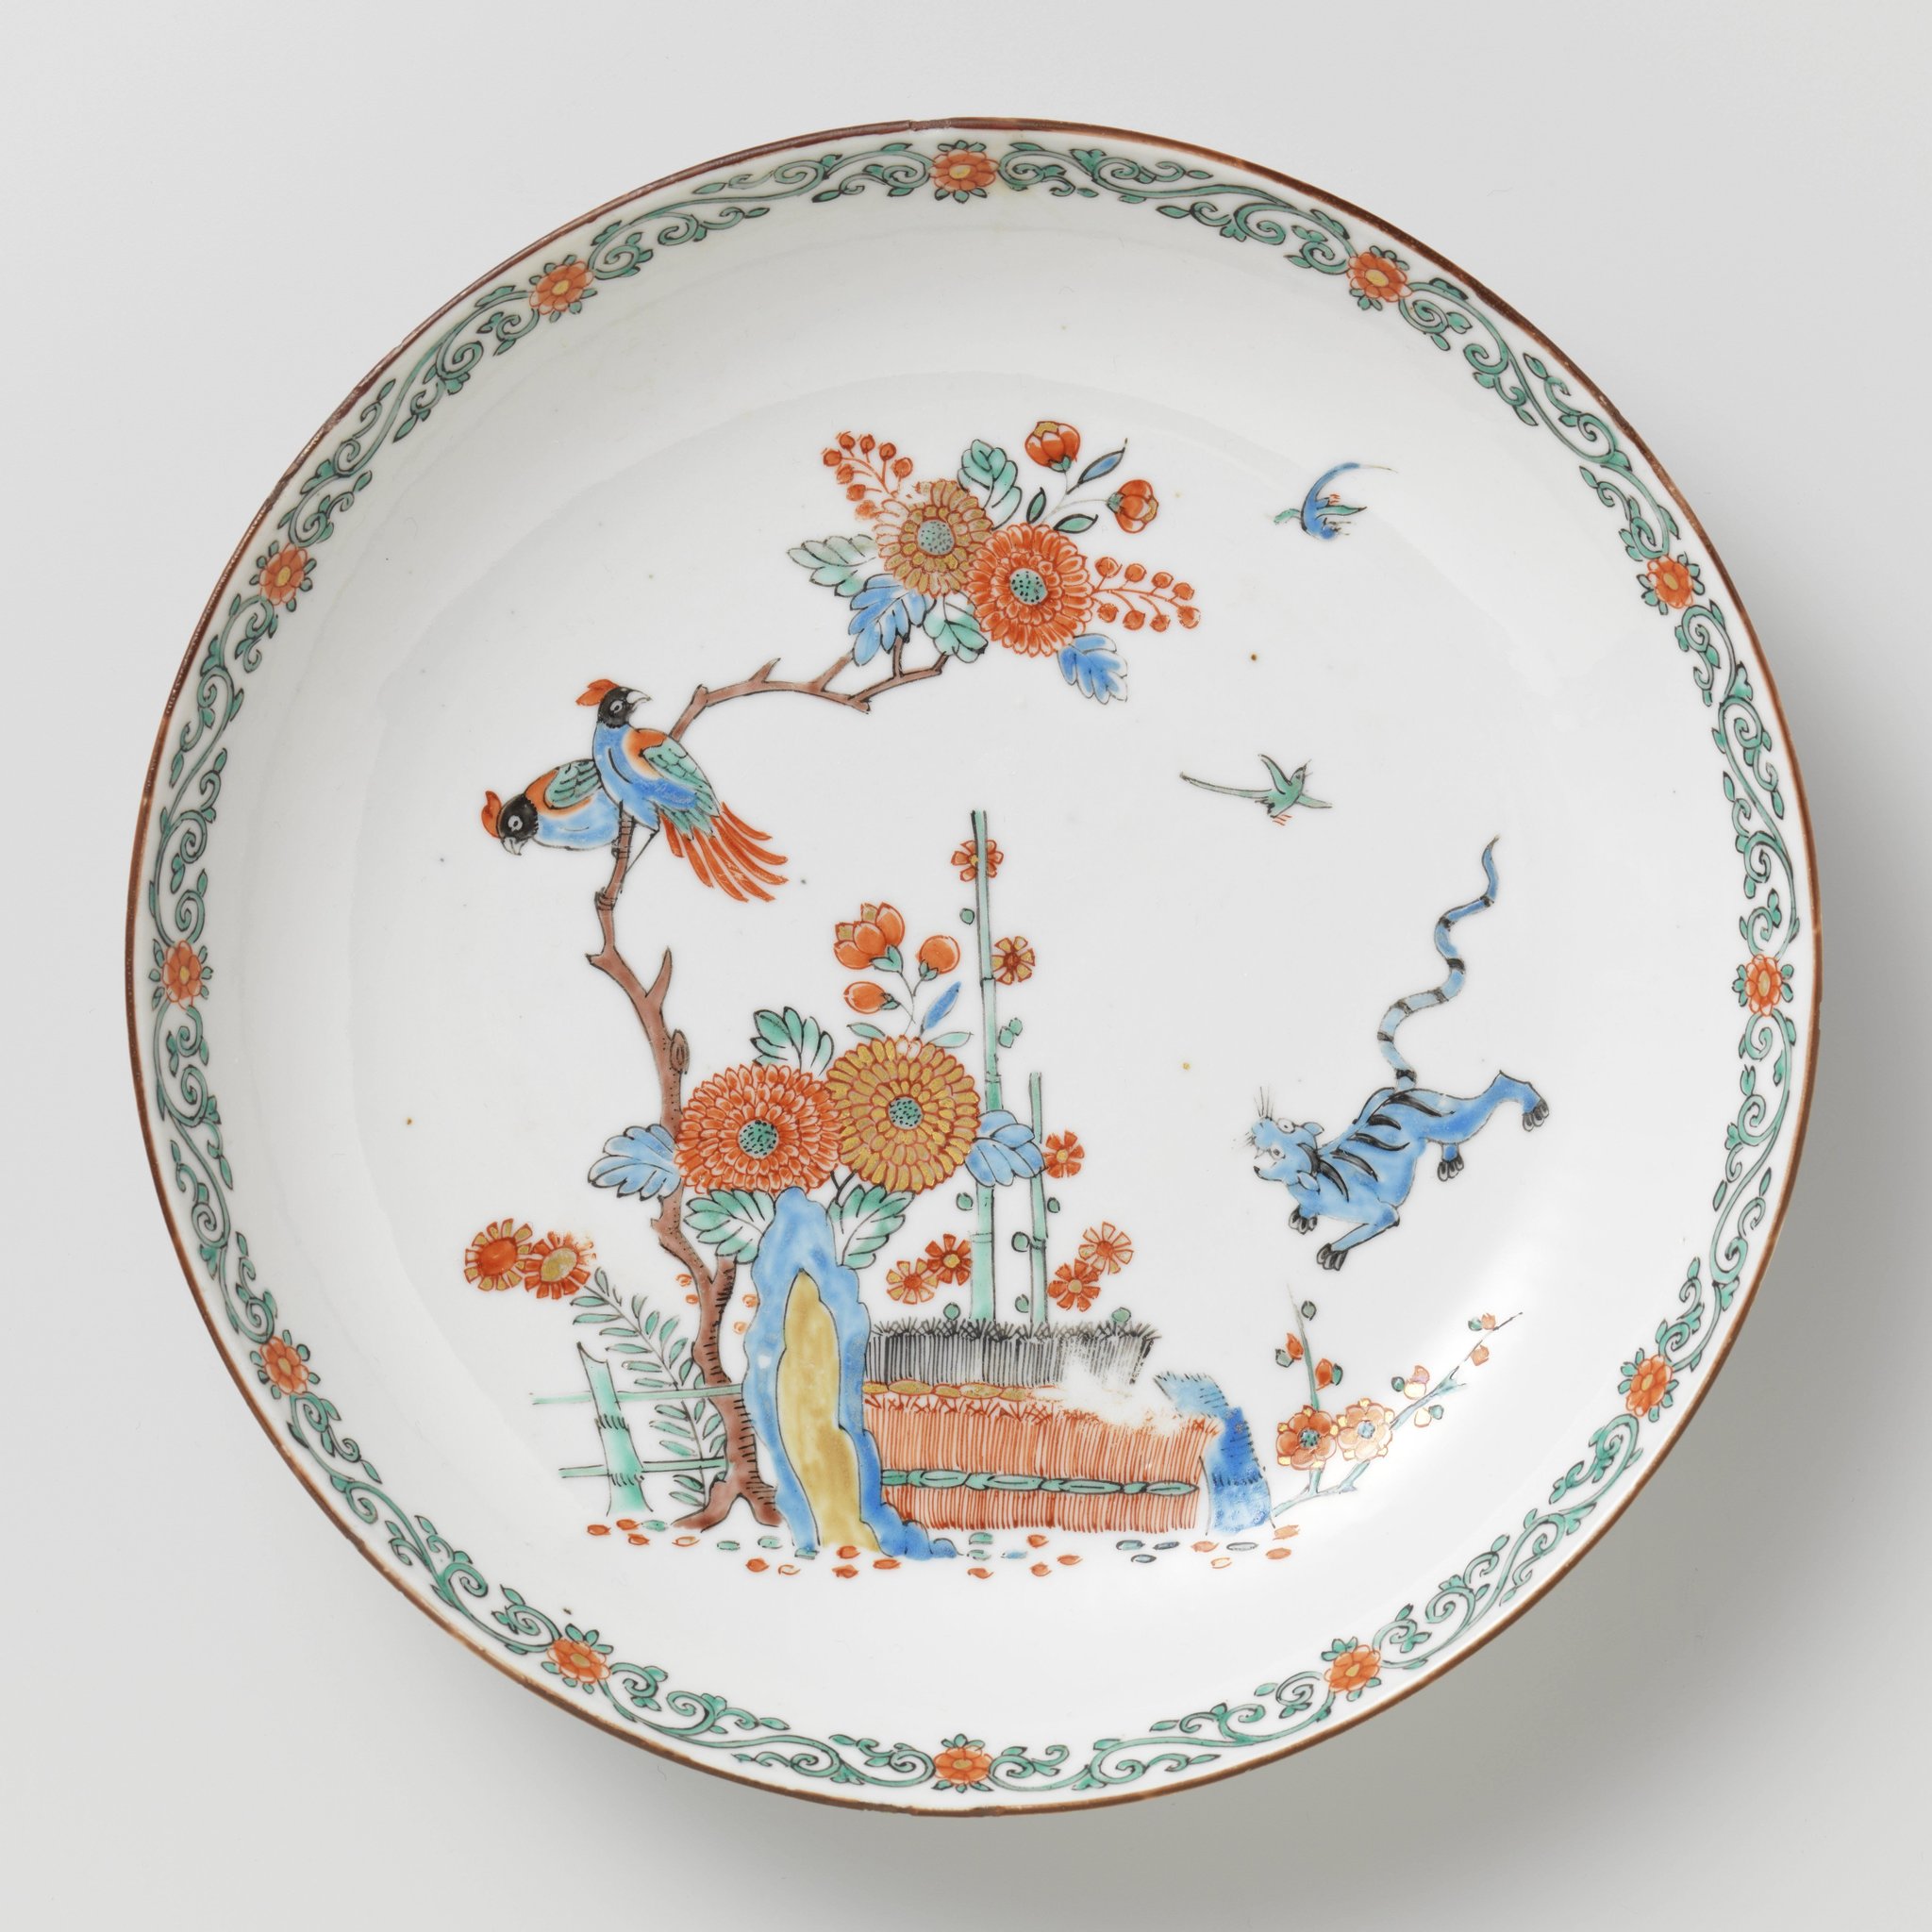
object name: dish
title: Saucer-dish with a tiger and two birds on a branch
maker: Anonymous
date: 1700-1724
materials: glaze, gold, paint, porcelain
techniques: firing, gilding, turning, vitrification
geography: europe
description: Schaal van porselein, beschilderd op het glazuur in blauw, rood, groen, geel, zwart en goud. In Europa beschilderd in emailkleuren met op het plat bloeiende planten (chrysant, bamboe, aster, prunus) achter bijeengebonden heggen en een rots. Op de chrysanttak twee vogels. Hiernaast een tijger en twee vliegende vogels. Op de binnenrand een band met bloemranken. Enkele chips in de bruine rand. In Europa gedecoreerd in de Japanse Kakiemon-stijl.